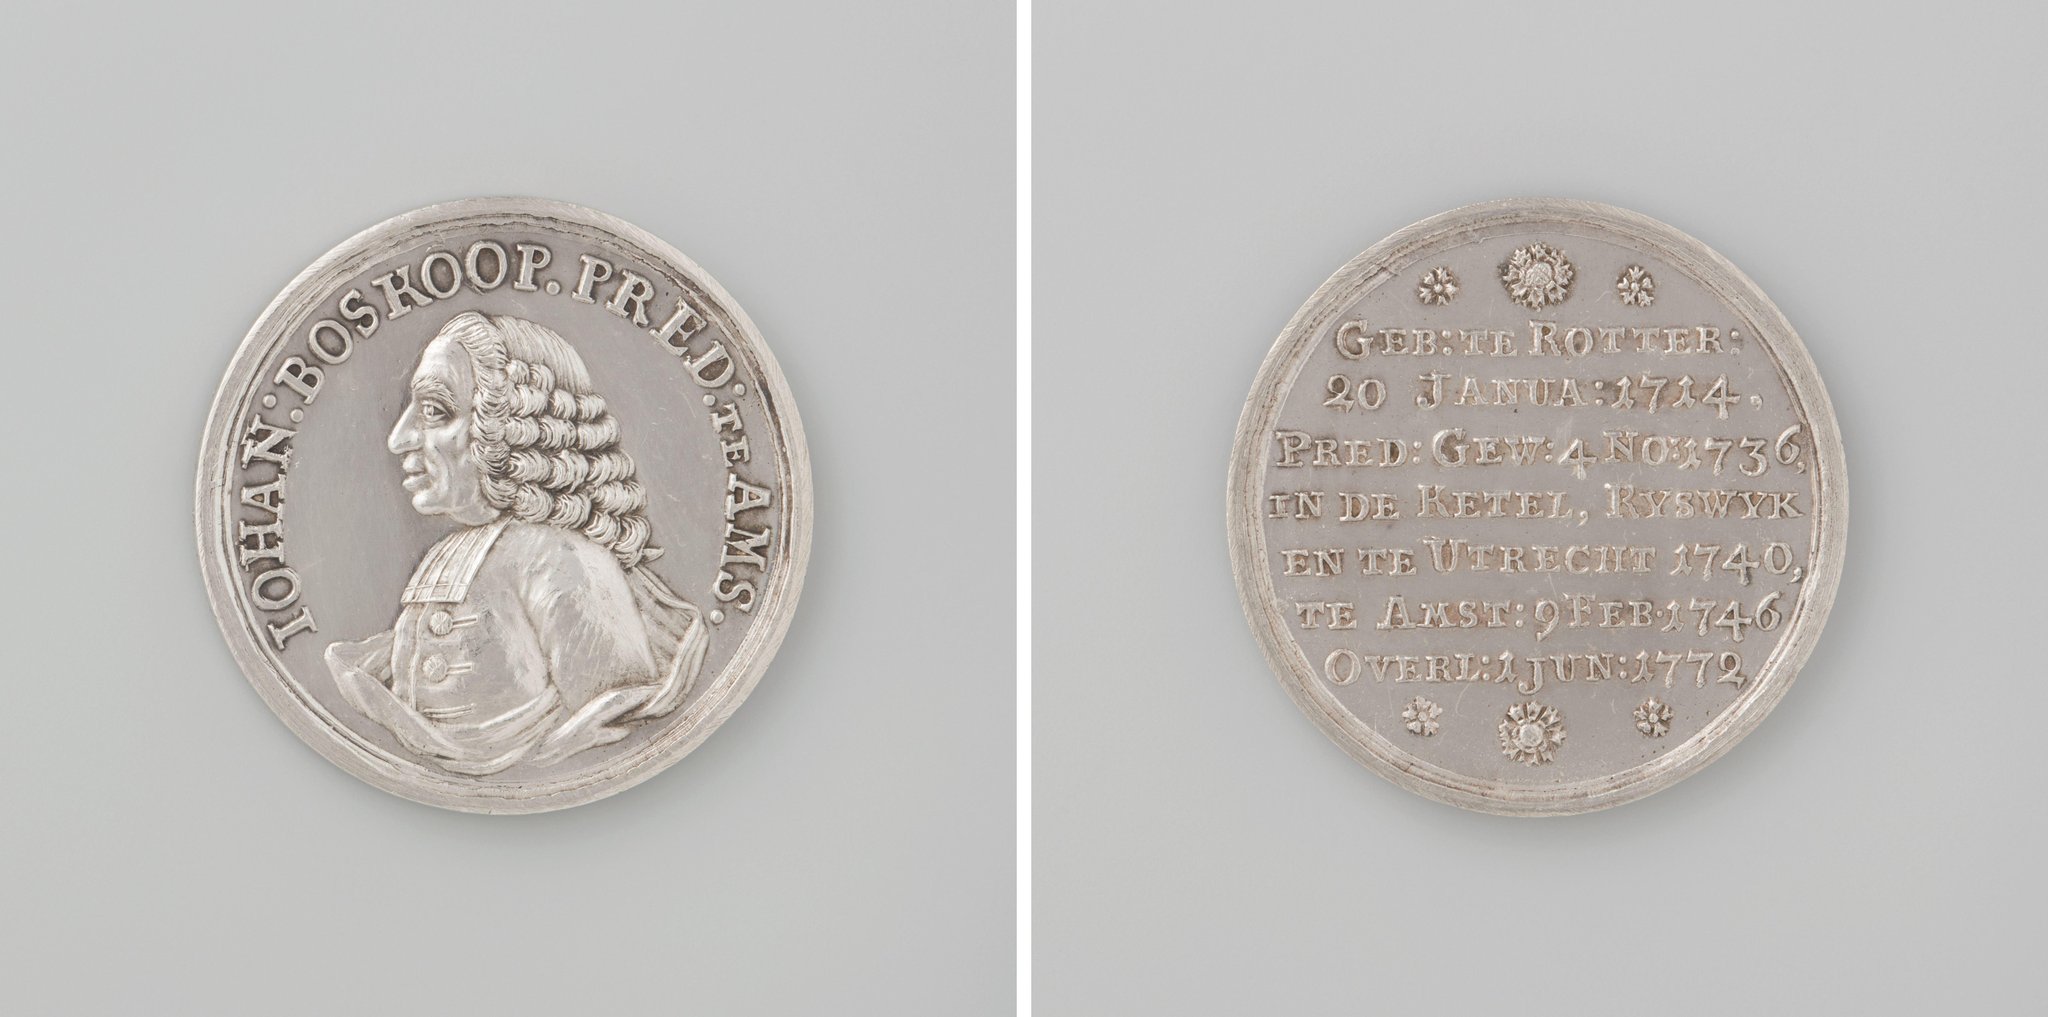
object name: overlijdenspenning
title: Overlijden van Johannes Boskoop, predikant te de Ketel, Rijswijk, Utrecht en Amsterdam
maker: Anonymous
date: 1772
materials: silver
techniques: striking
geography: netherlands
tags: amsterdam, johannes van boskoop, utrecht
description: Zilveren penning. Voorzijde: borststuk man binnen omschrift. Keerzijde: opschrift tussen bloemen